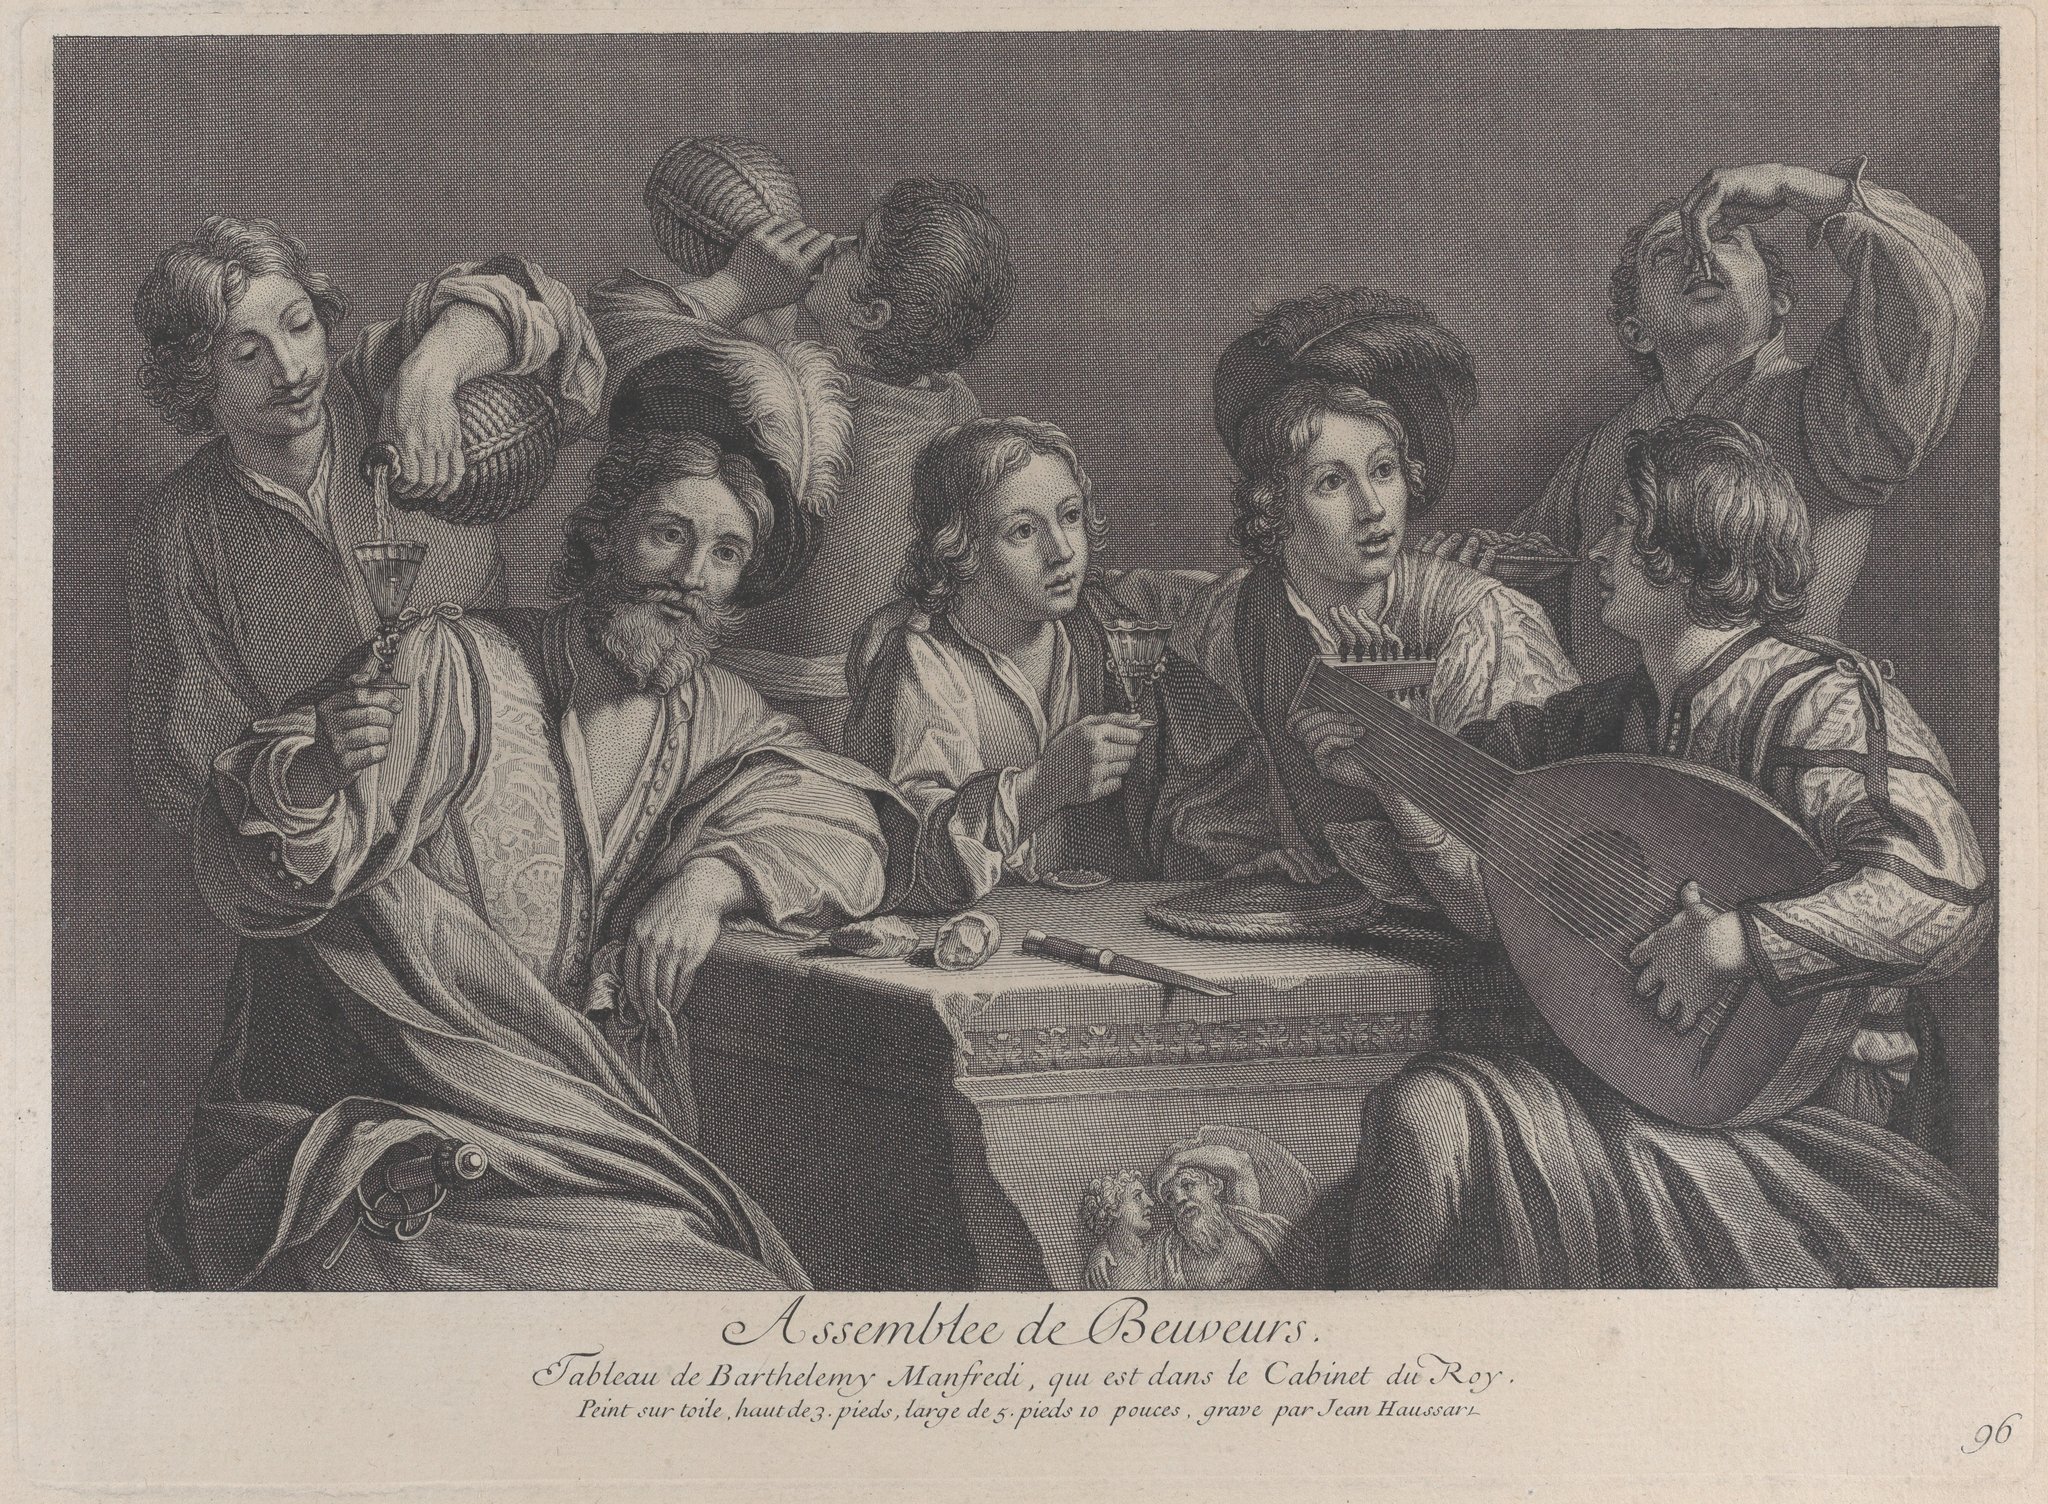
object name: print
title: Seven men gathered around a table, drinking and listening to a lute player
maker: jean-baptiste haussard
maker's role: artist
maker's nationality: french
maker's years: 1679-1749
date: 1729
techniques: engraving, etching